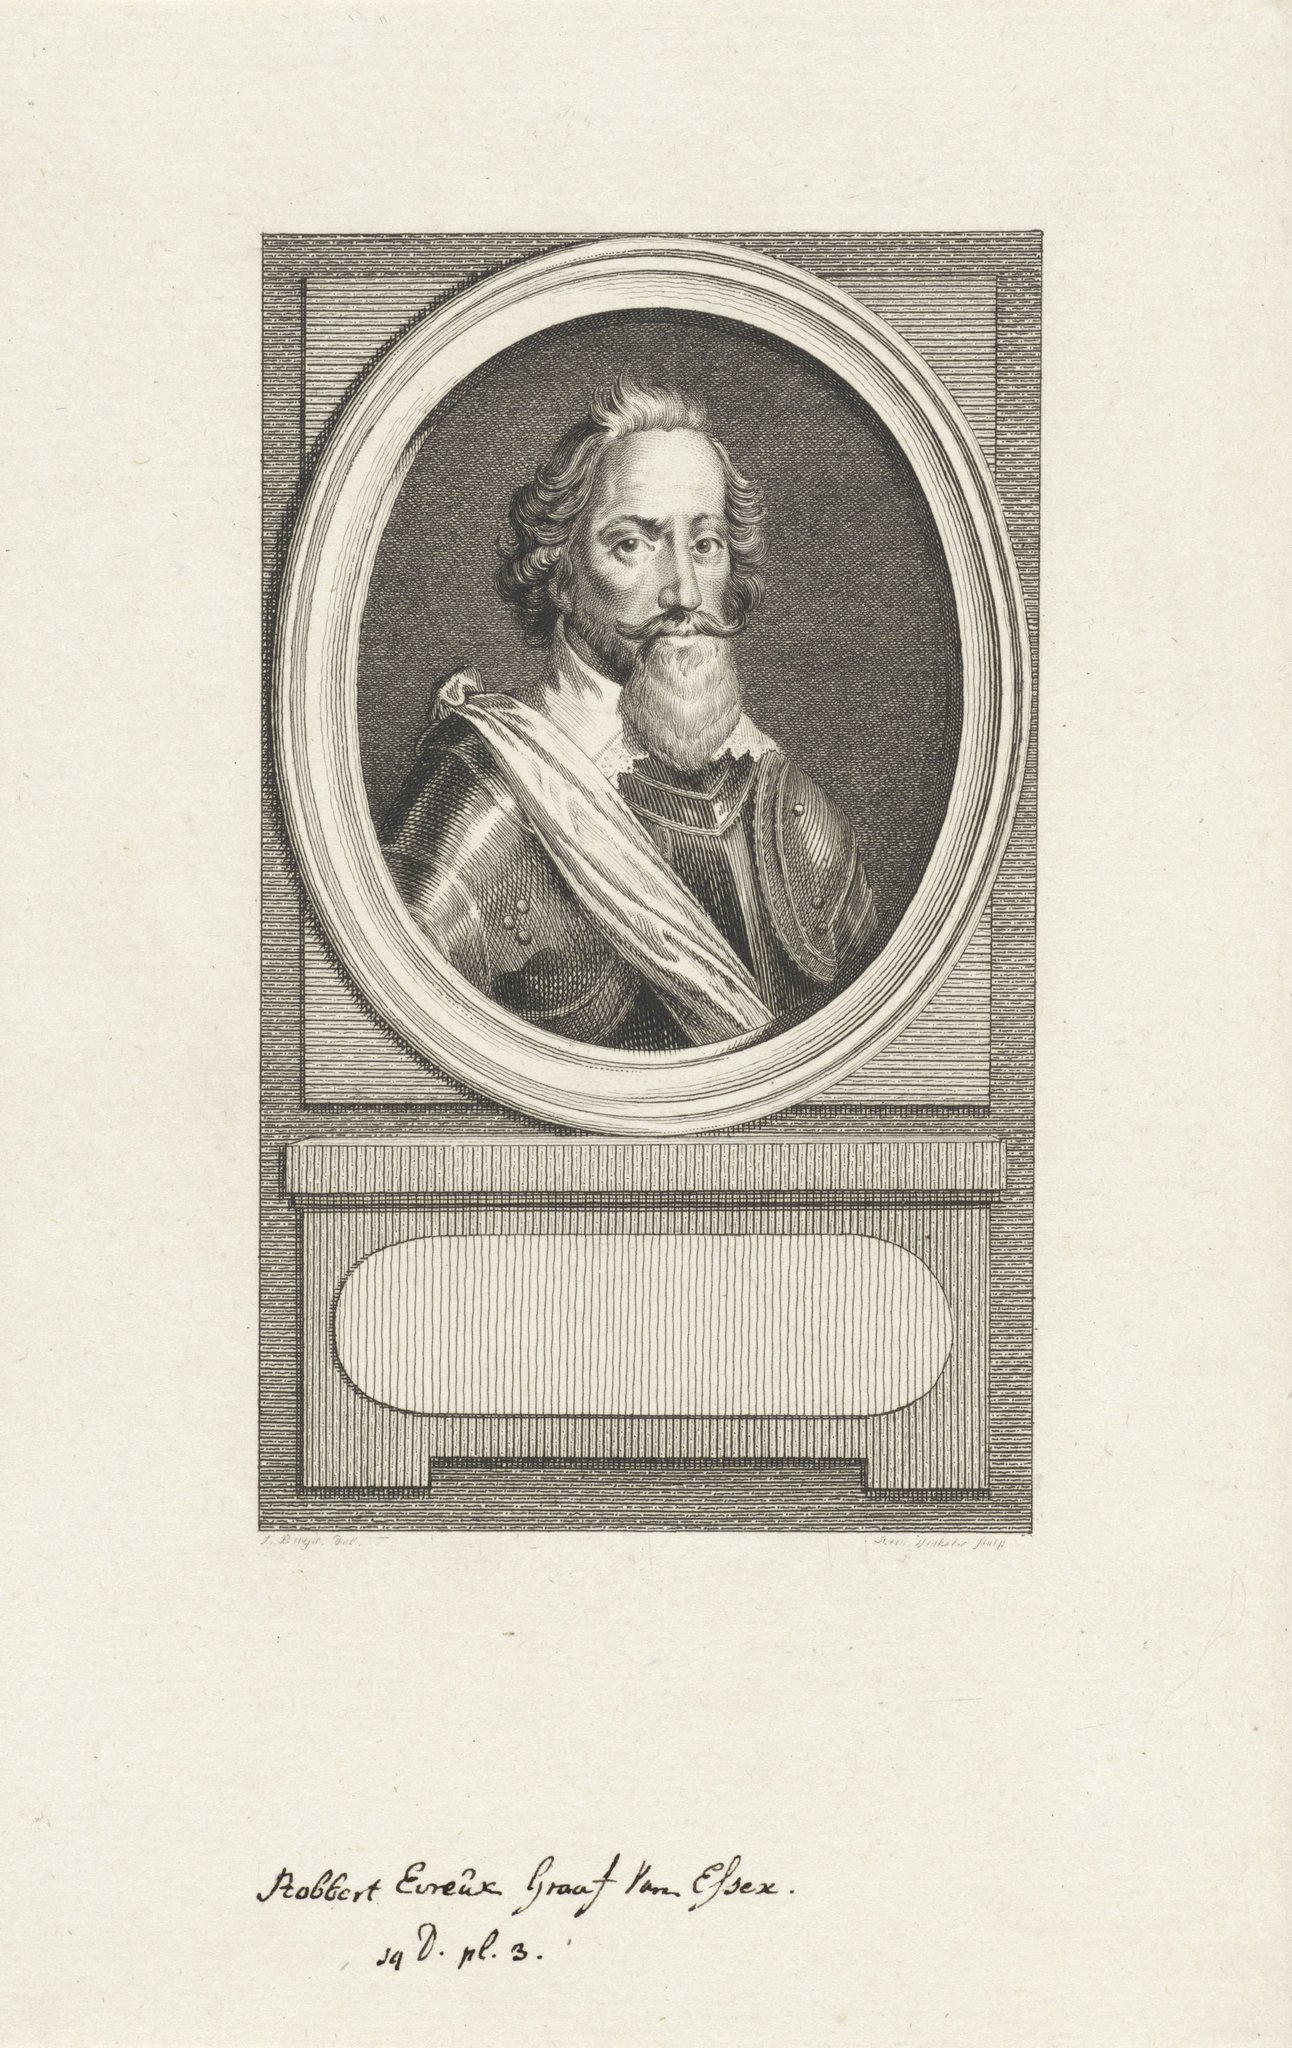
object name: print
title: Portret van Robert Devreux, graaf van Essex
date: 1785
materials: paper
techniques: engraving, etching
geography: amsterdam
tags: london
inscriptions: collector's mark: Lugt 240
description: Latere staat prent gebruikt als boekillustratie in: Kok, Jacobus. Vaderlandsch woordenboek : met kaarten, plaaten en pourtraitten. Amsterdam: Johannes Allart, 1785-1796. Deel XIV.